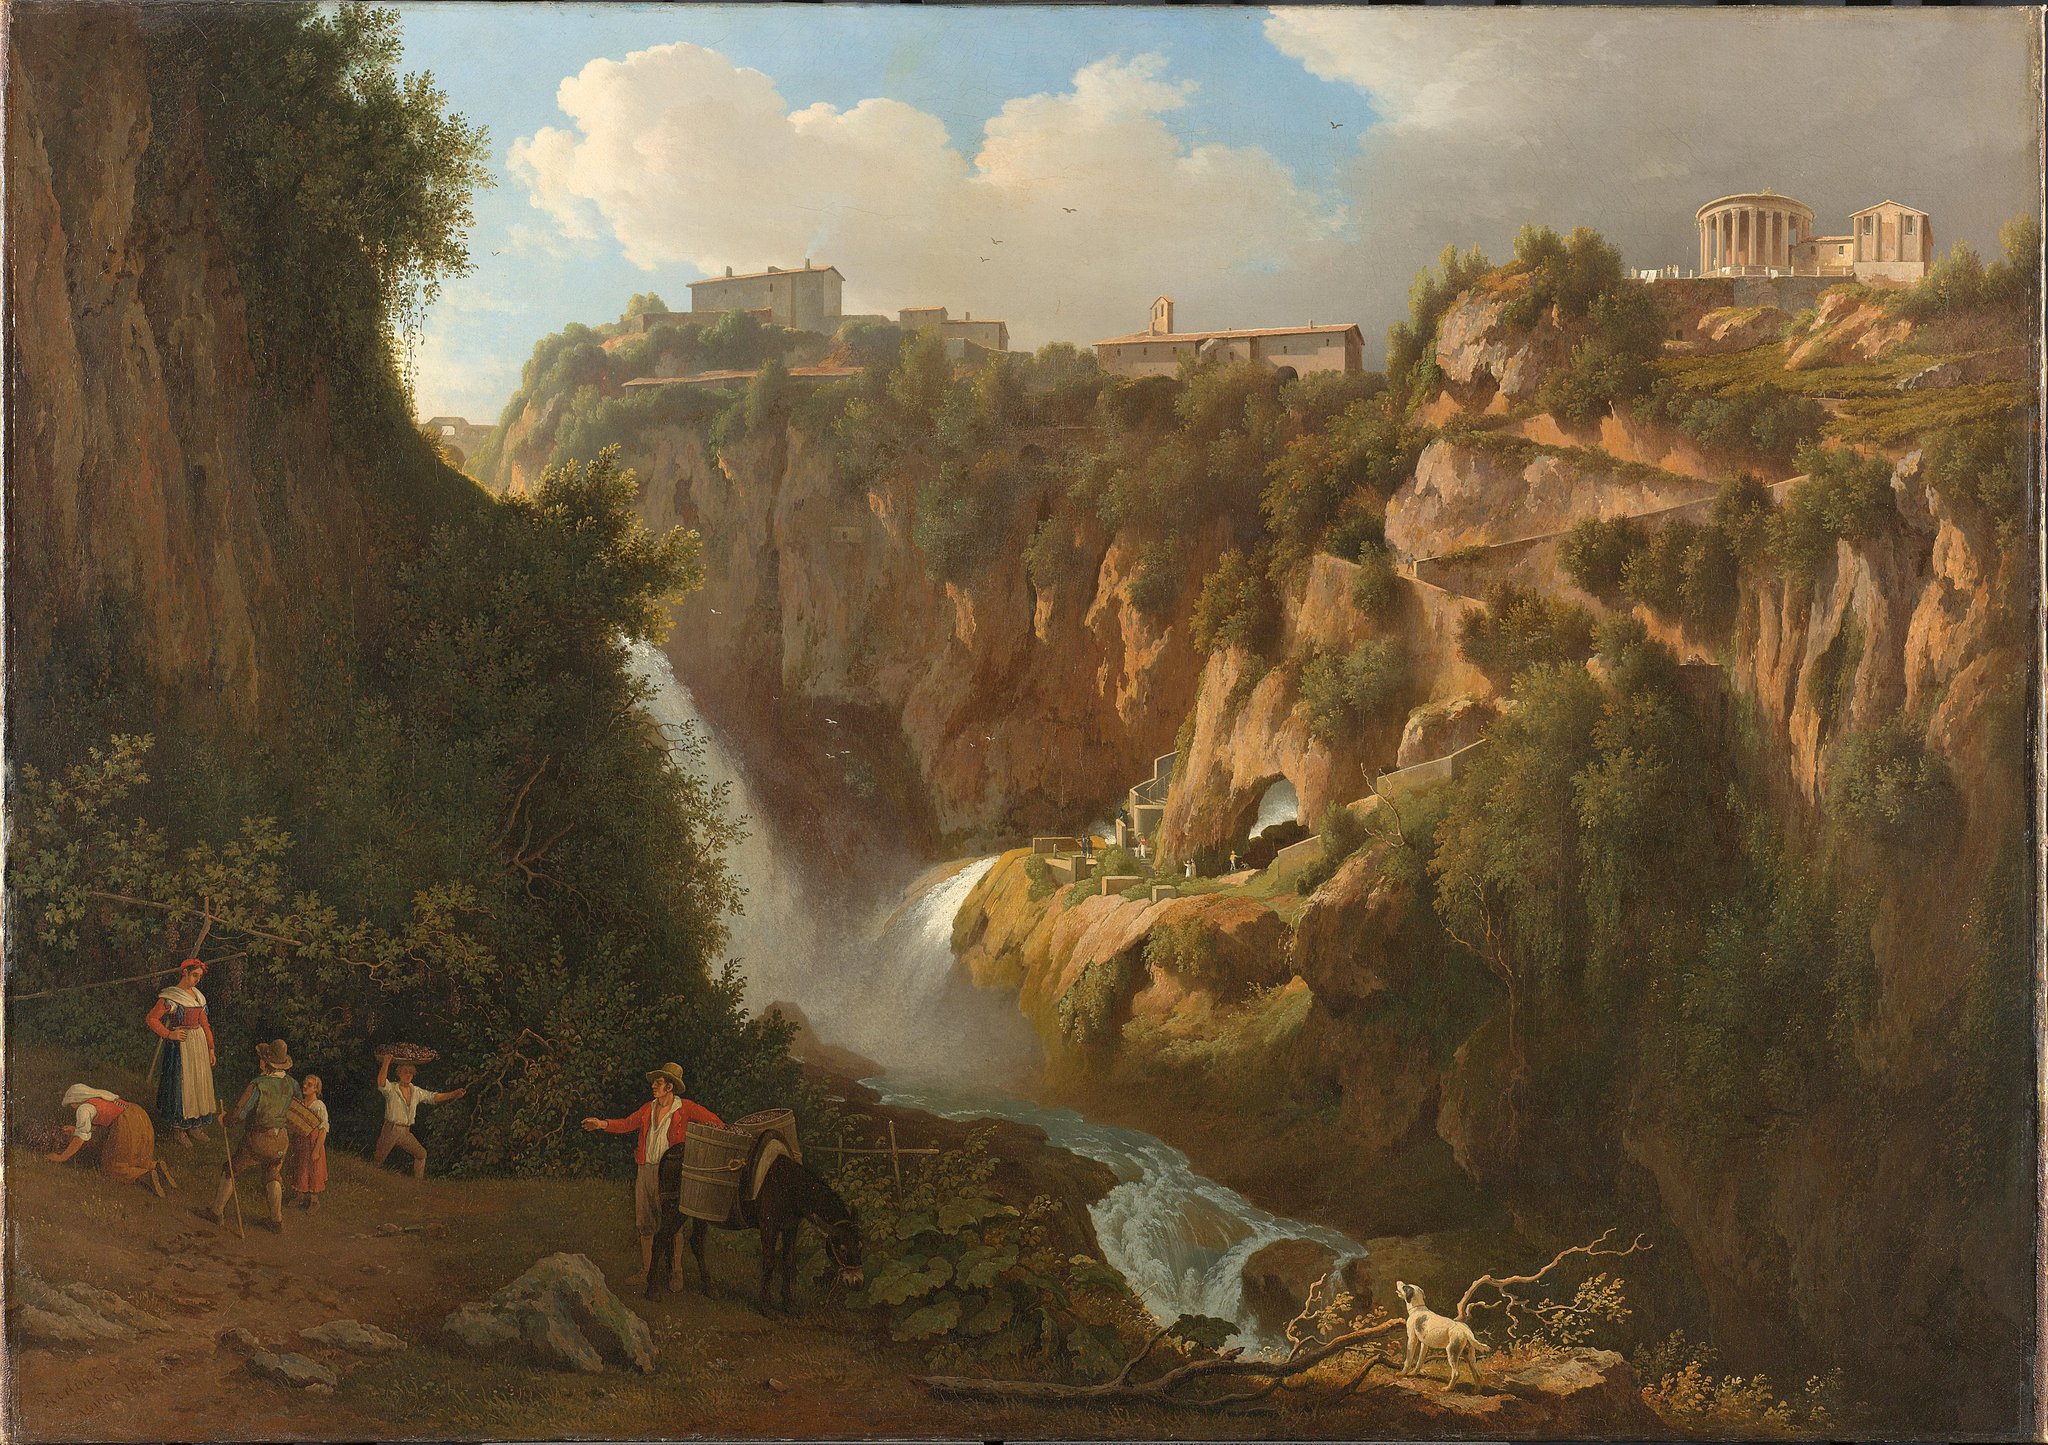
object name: painting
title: The Waterfall at Tivoli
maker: abraham teerlink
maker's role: draughtsman, painter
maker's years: 1776-1857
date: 1824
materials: canvas, oil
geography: rome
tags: waterfall, temple, shrine ~ roman religion, tivoli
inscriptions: signature and date: ‘Teerlink F. Romae 1824’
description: In 1807 Abraham Teerlink received a grant from Louis Napoleon to travel to Italy. After the King’s abdication, he decided to stay there and became a highly success-ful landscape painter. These two views of Tivoli, near Rome, are pendants. On top of the hill is the village of Tivoli, and in the background is the circular Temple of Vesta, goddess of domestic harmony.